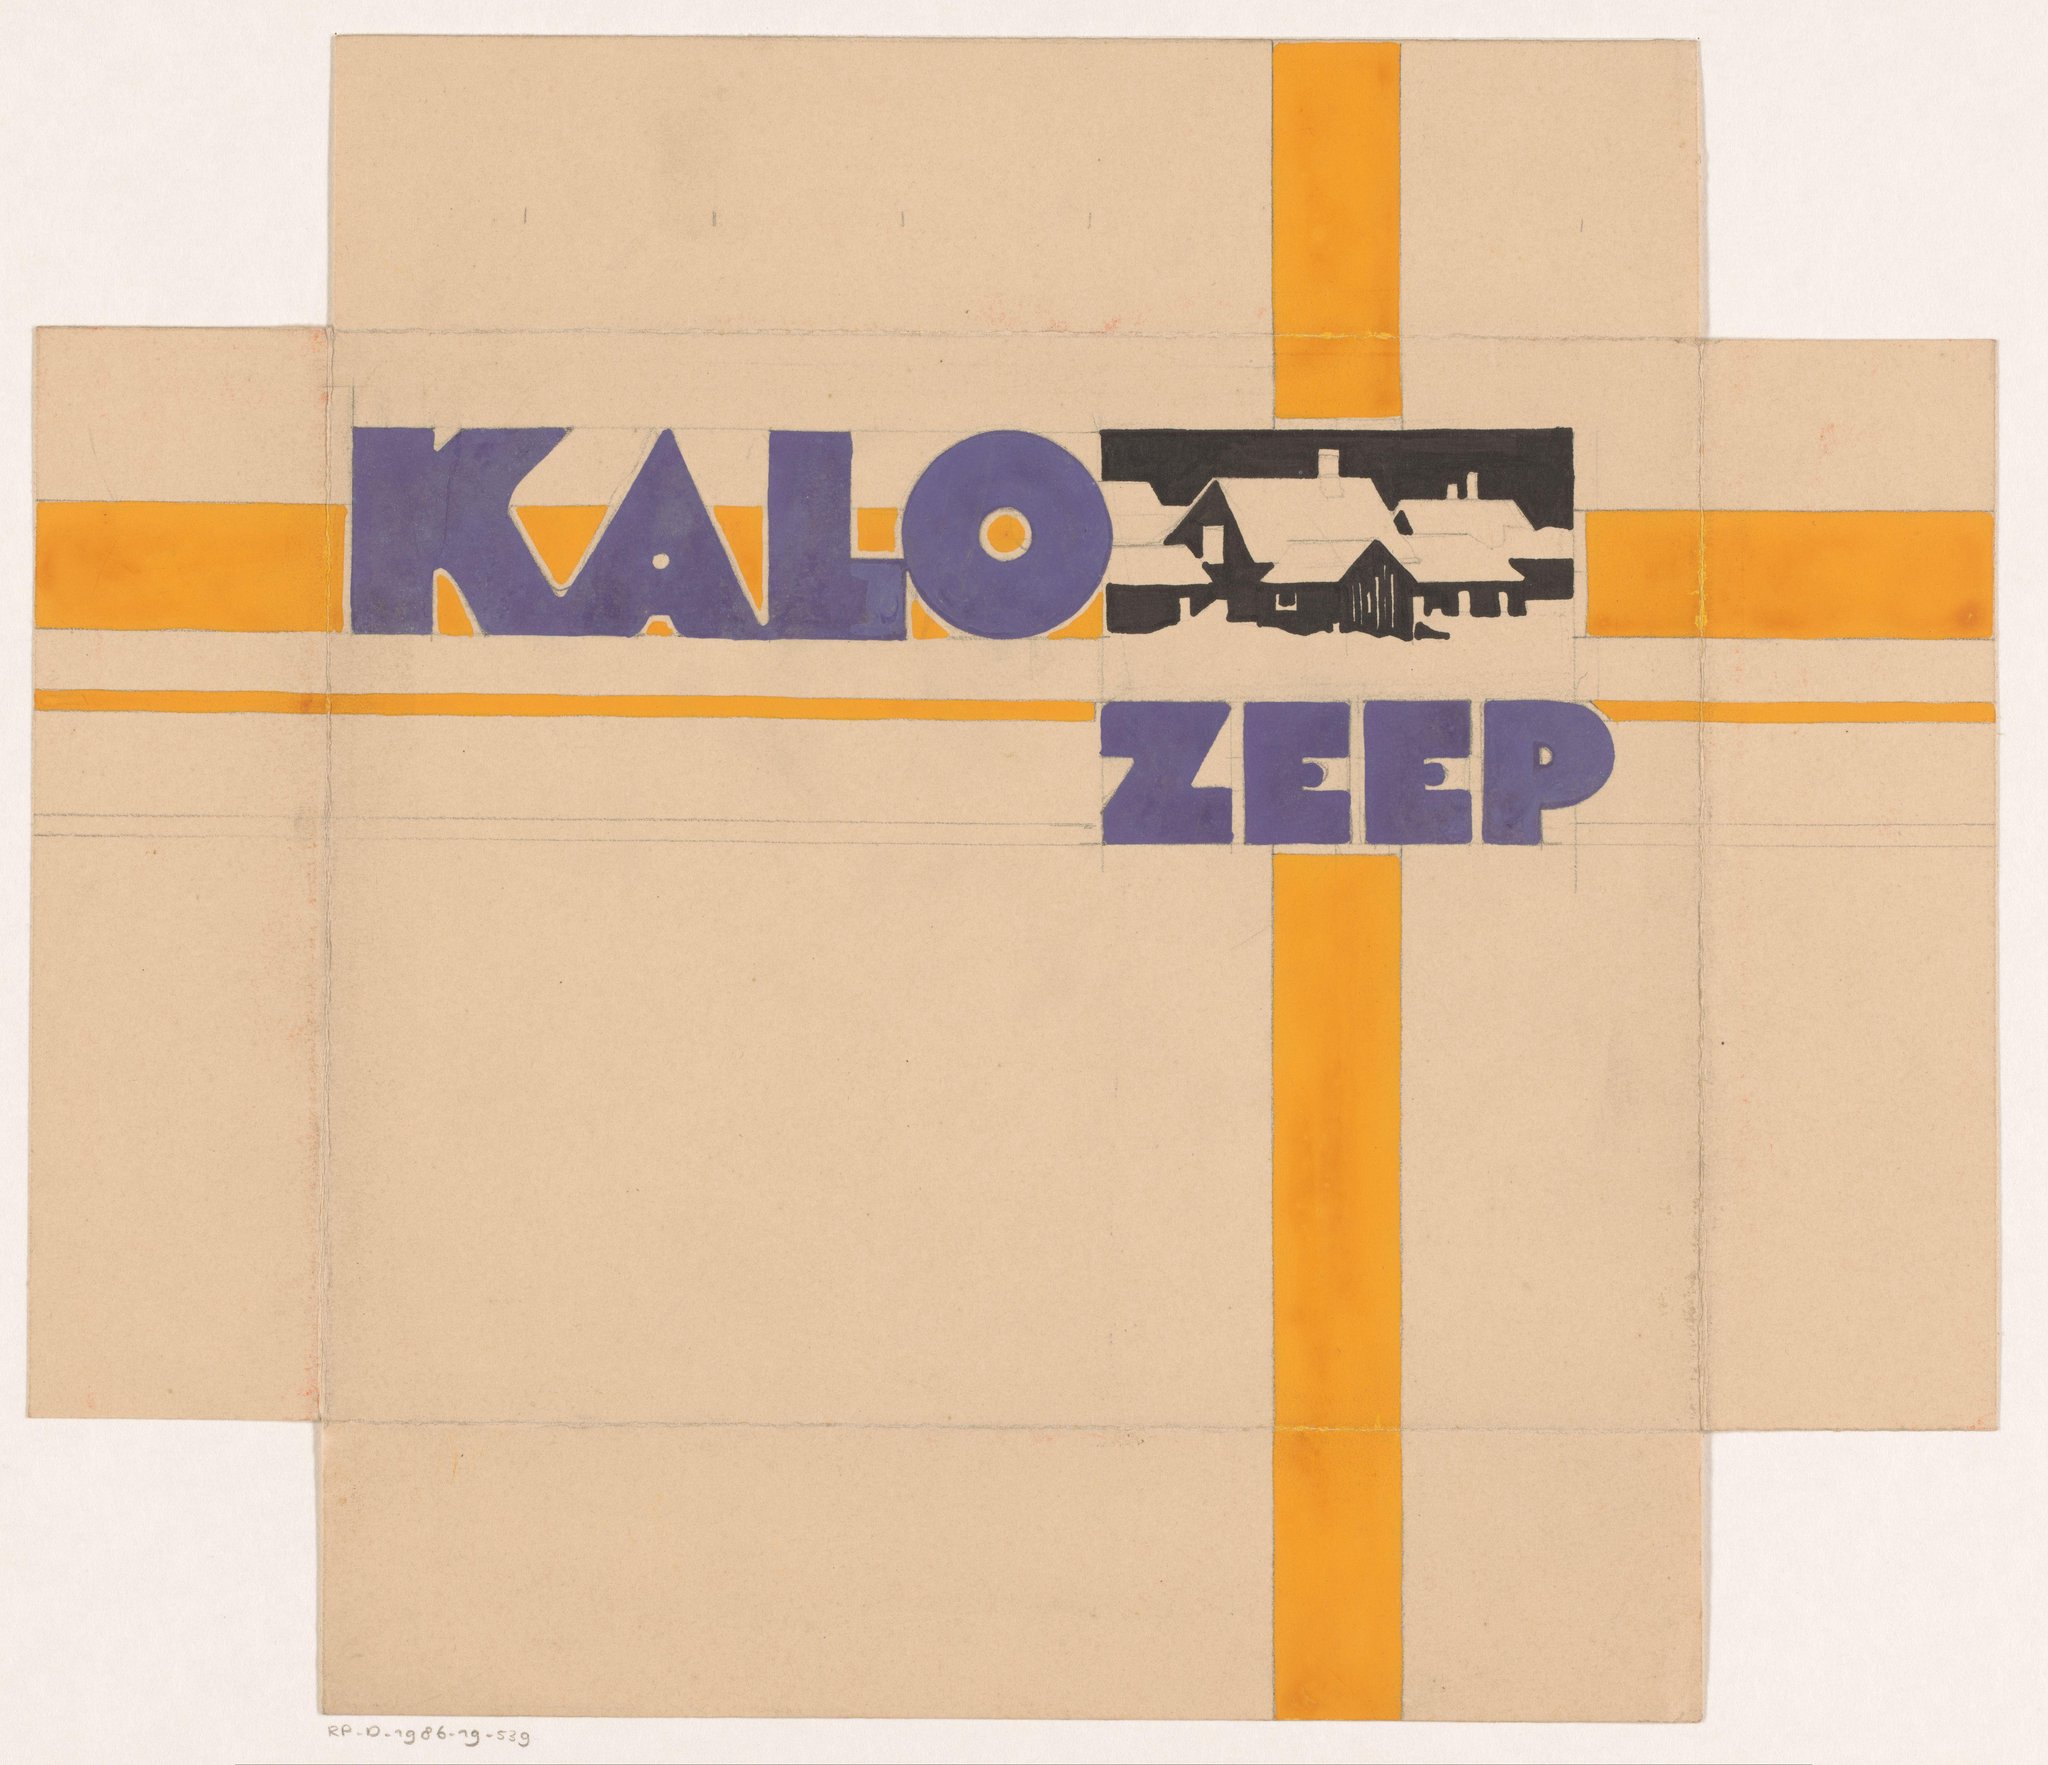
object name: drawing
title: Ontwerp voor een verpakking of advertentie van Kalo zeep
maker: reinier willem petrus de vries (1874-1953)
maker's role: draughtsman, print maker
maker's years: 1874-1953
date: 1884-1952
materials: ink, paint, paper, pencil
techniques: brush, pen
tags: prospect of village, silhouette of village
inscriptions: collector's mark: ‘R:MVS.’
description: Ontwerp met lijnen en een gezicht op een dorp.